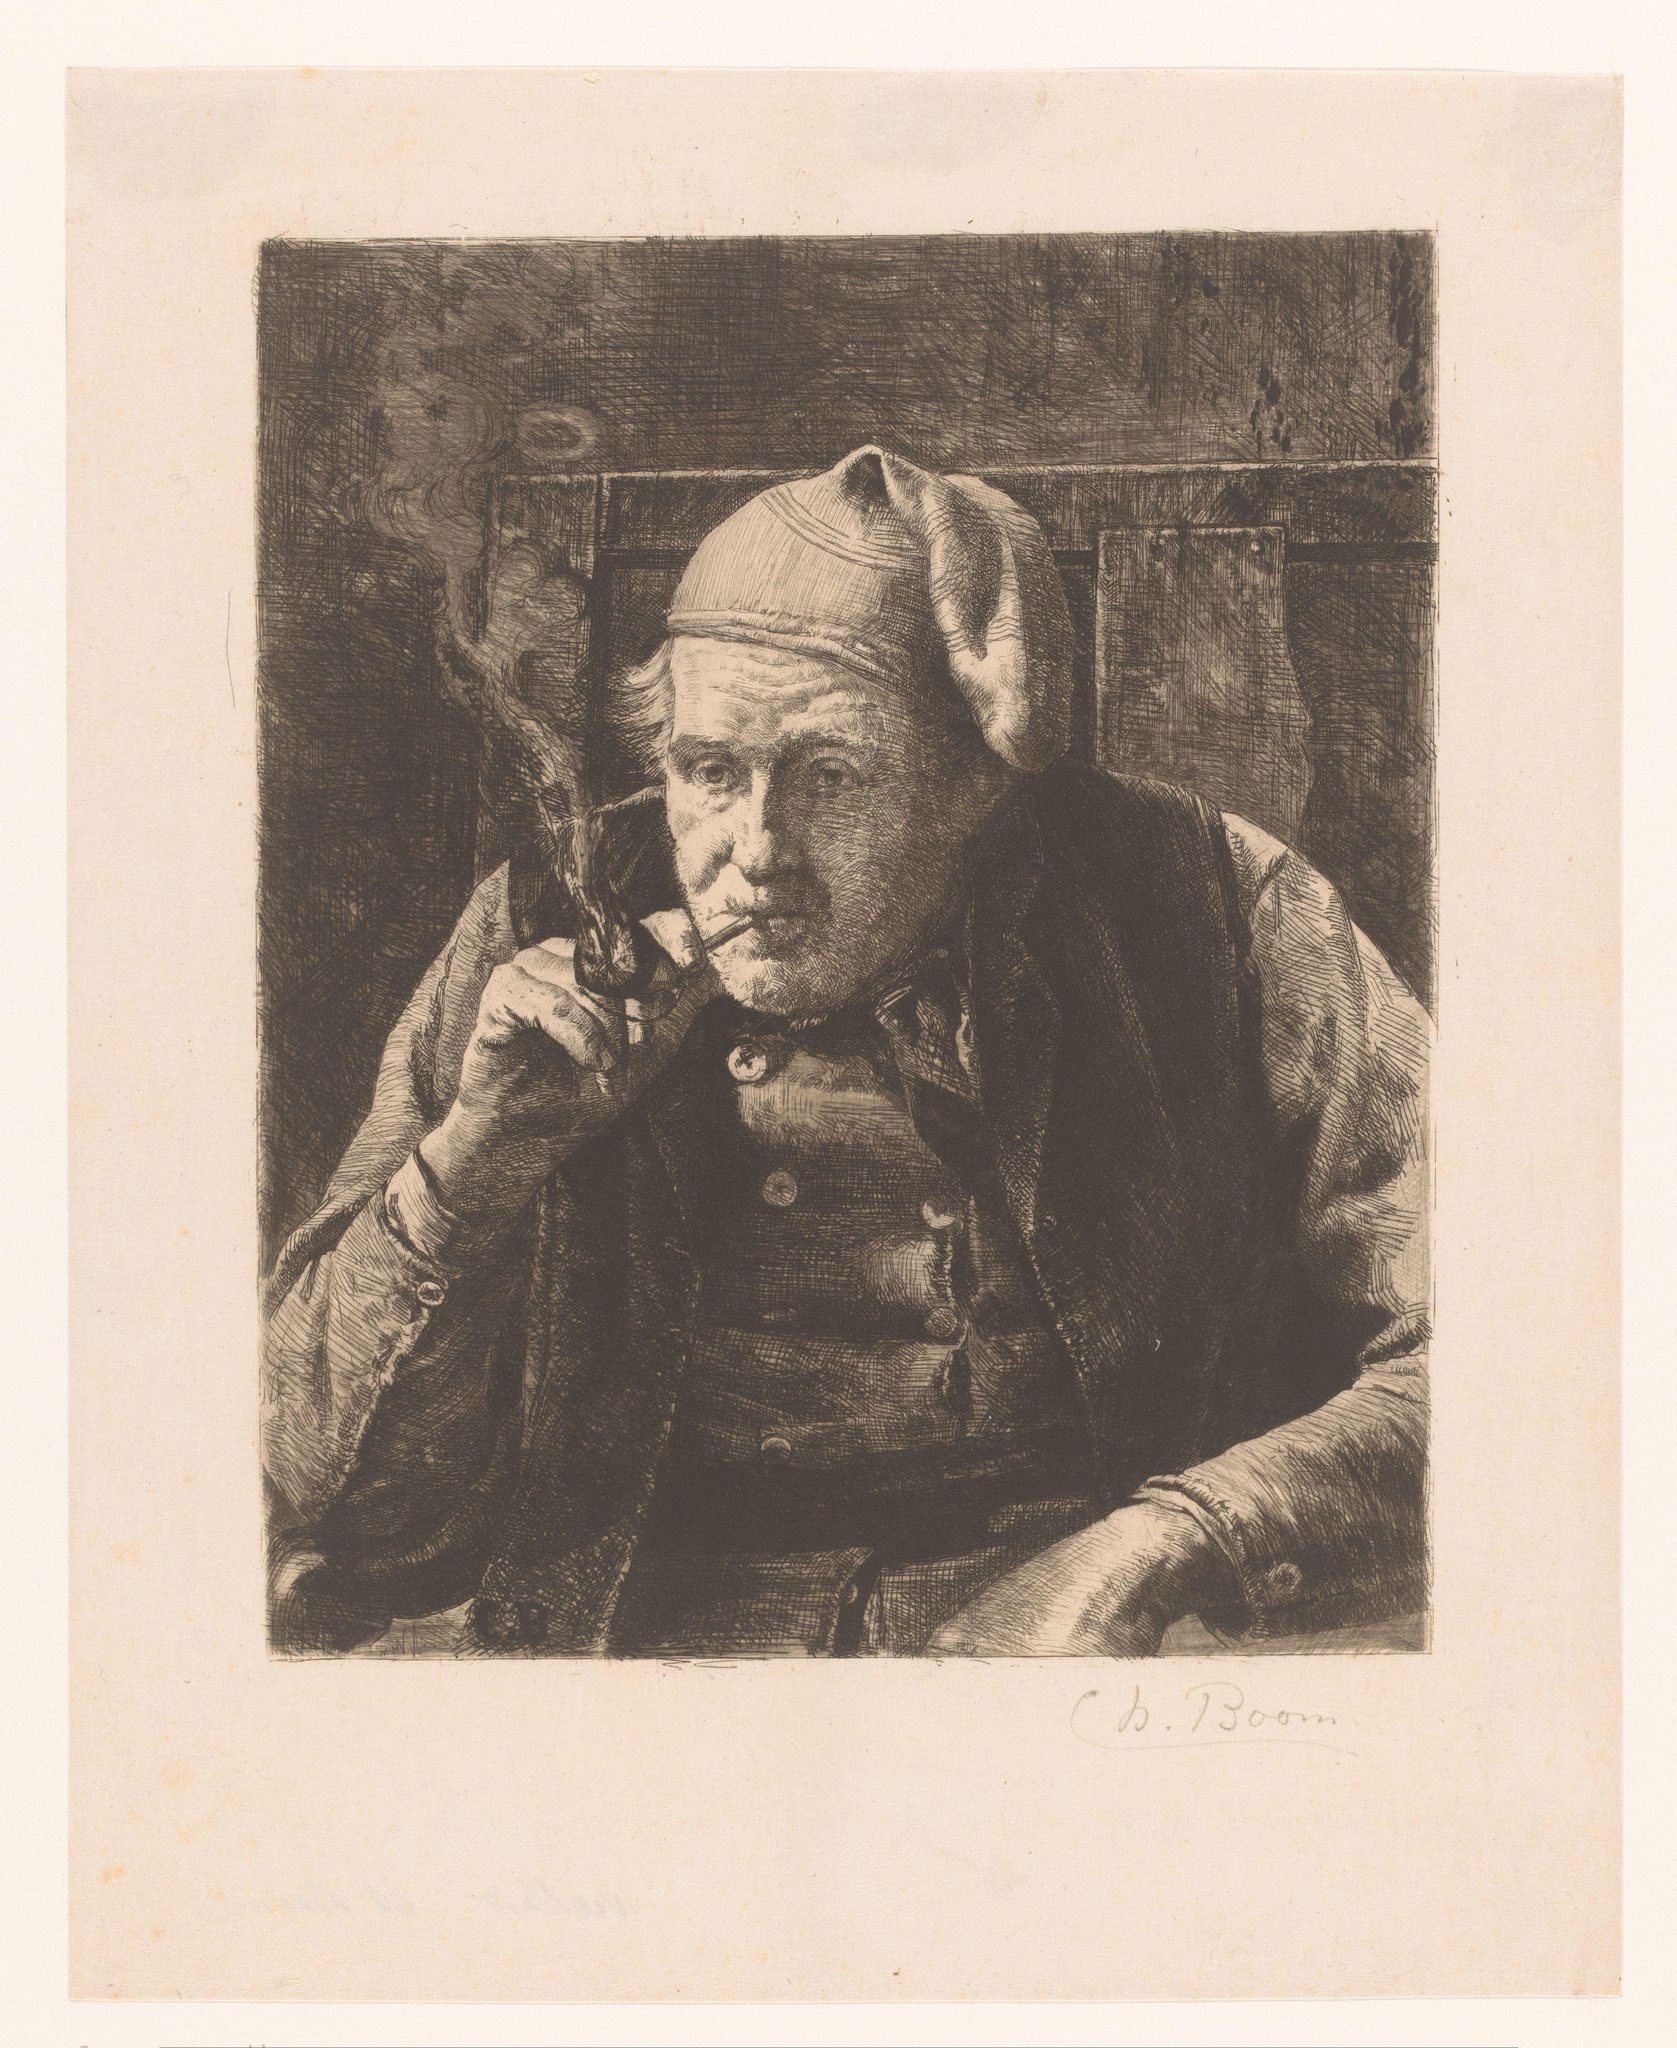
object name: print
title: Pijp rokende oude man met slaapmuts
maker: charles boom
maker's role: print maker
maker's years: 1858-1939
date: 1880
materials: paper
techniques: drypoint, etching, intaglio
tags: pipe ~ tobacco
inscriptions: collector's mark: Lugt 2228, mark: ‘Antwerpsche Etsers 1880’